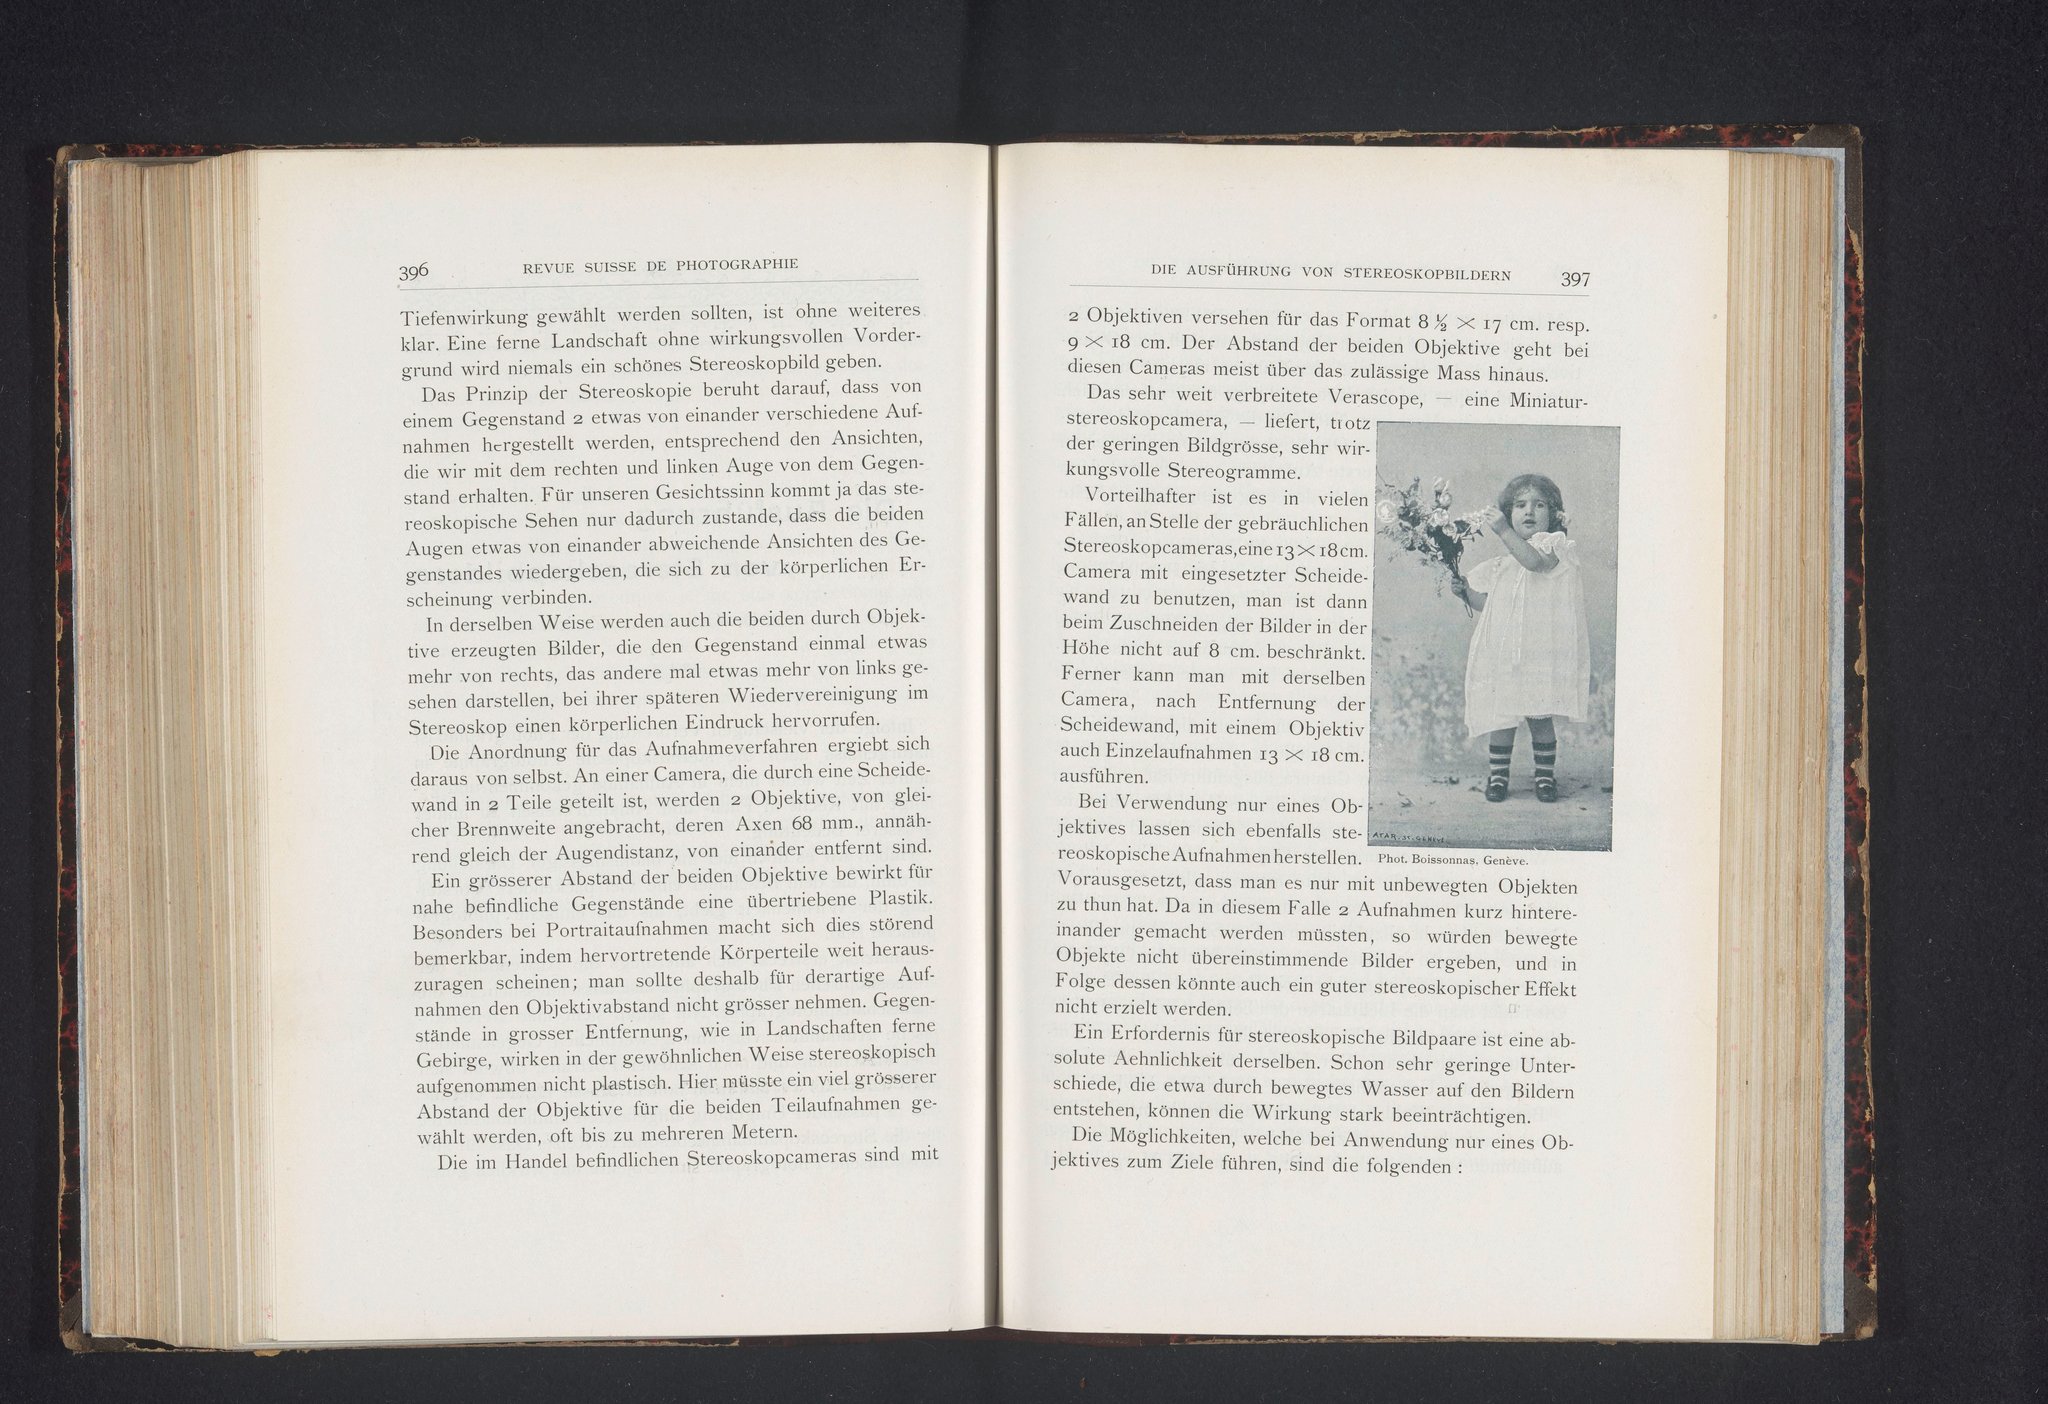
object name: page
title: Meisje met bloemen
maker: frédéric boissonnas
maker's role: fotograaf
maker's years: 1858-1946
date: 1897-1902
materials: paper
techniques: autotype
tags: cut flowers; nosegay, bunch of flowers, historical persons - bb - woman, girl (child between toddler and youth)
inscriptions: monogram: ‘C. Cie’